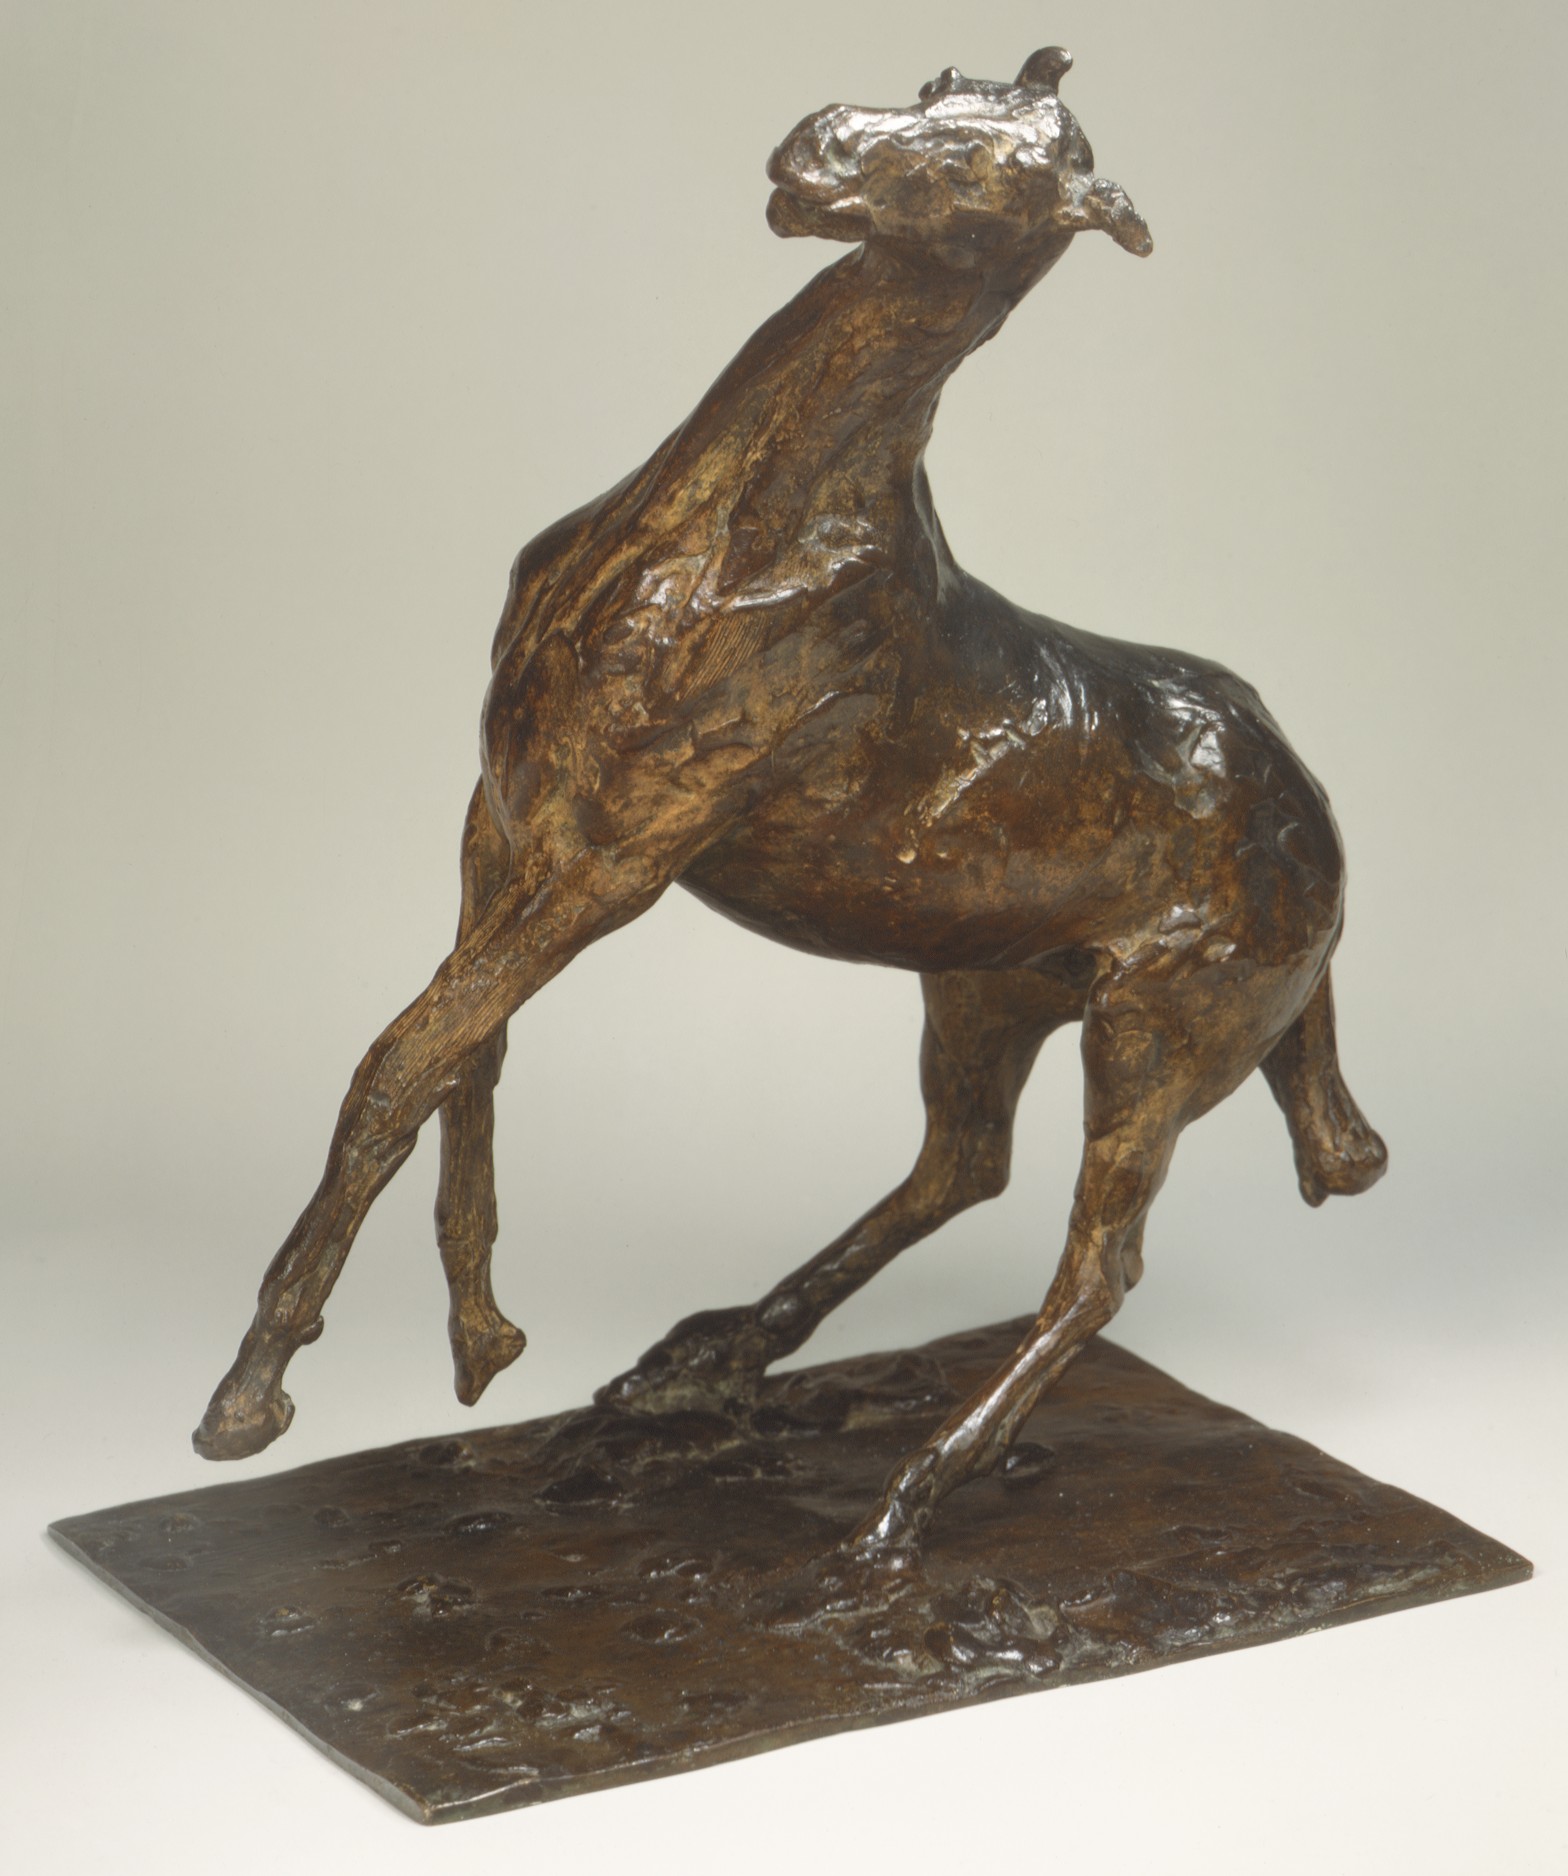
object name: statuette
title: Rearing Horse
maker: edgar degas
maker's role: artist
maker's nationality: french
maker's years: 1834-1917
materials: bronze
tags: horses